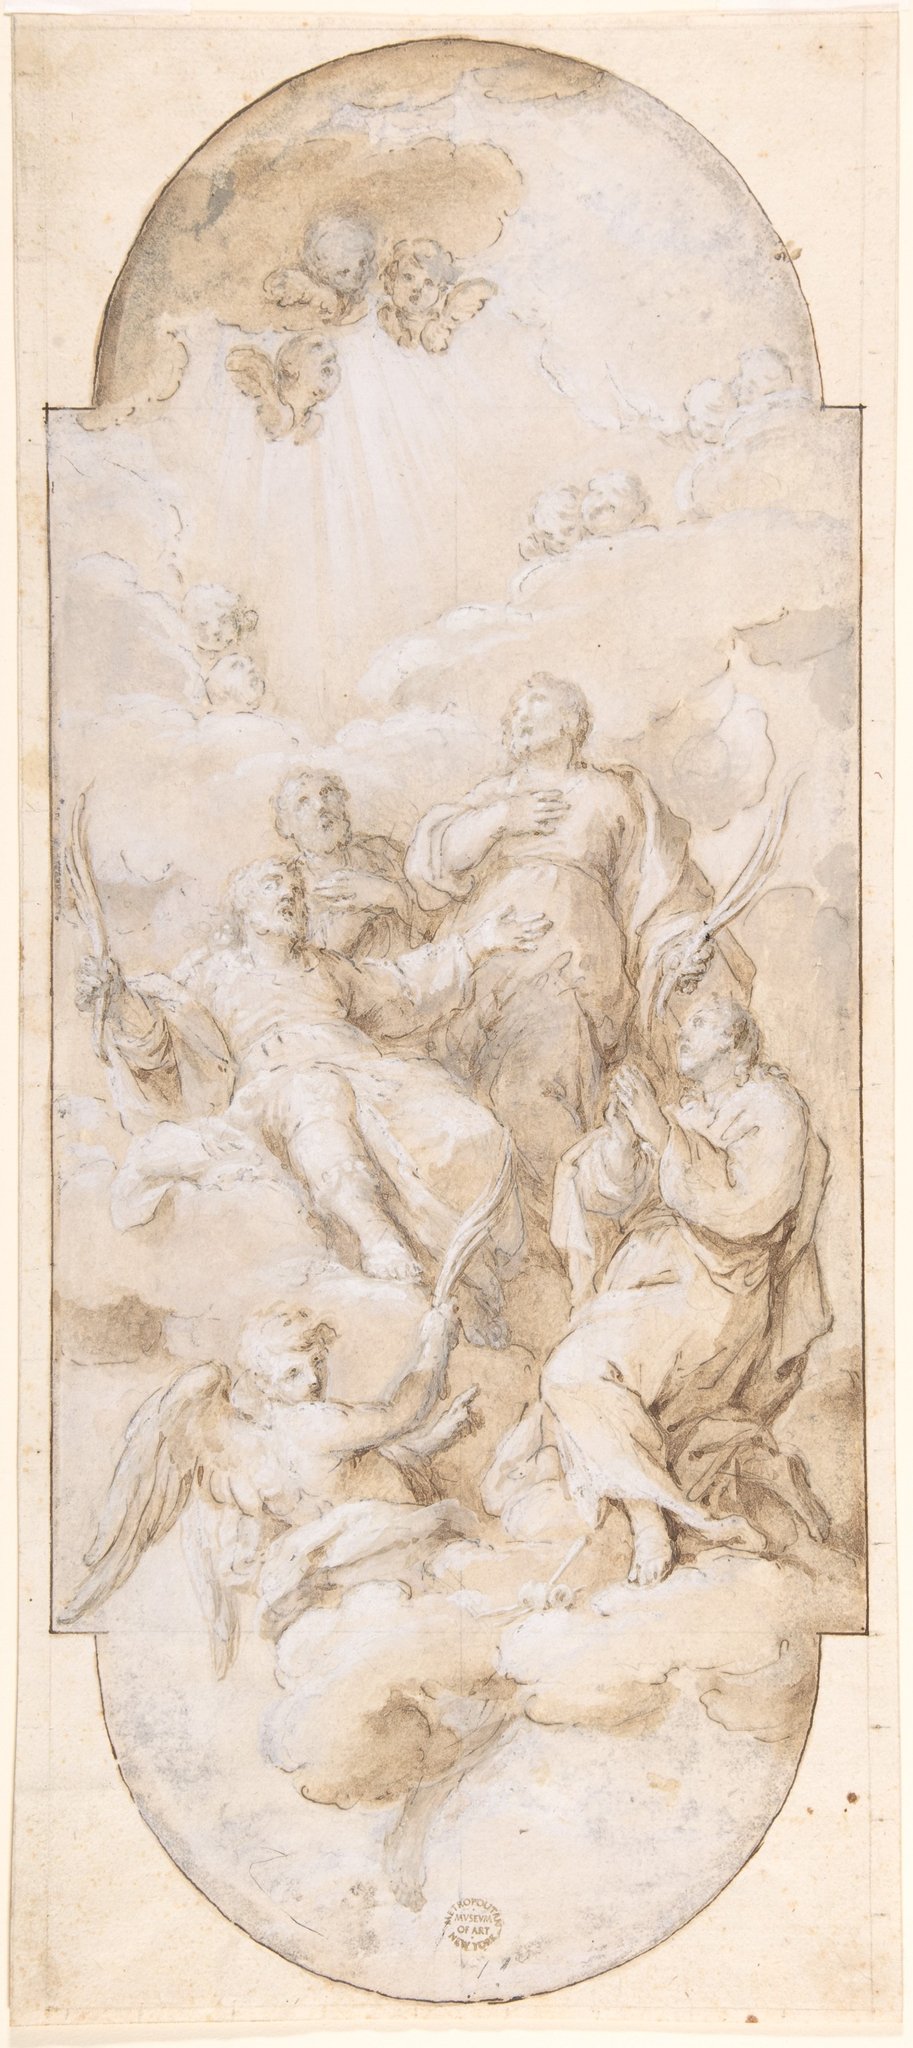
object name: drawing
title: Apotheosis of Four Martyred Saints (Four Crowned Martyrs?)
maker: antonio cavallucci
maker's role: artist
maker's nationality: italian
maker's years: 1752-1795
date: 1601-1700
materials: ink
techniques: pen, wash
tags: angels,saints